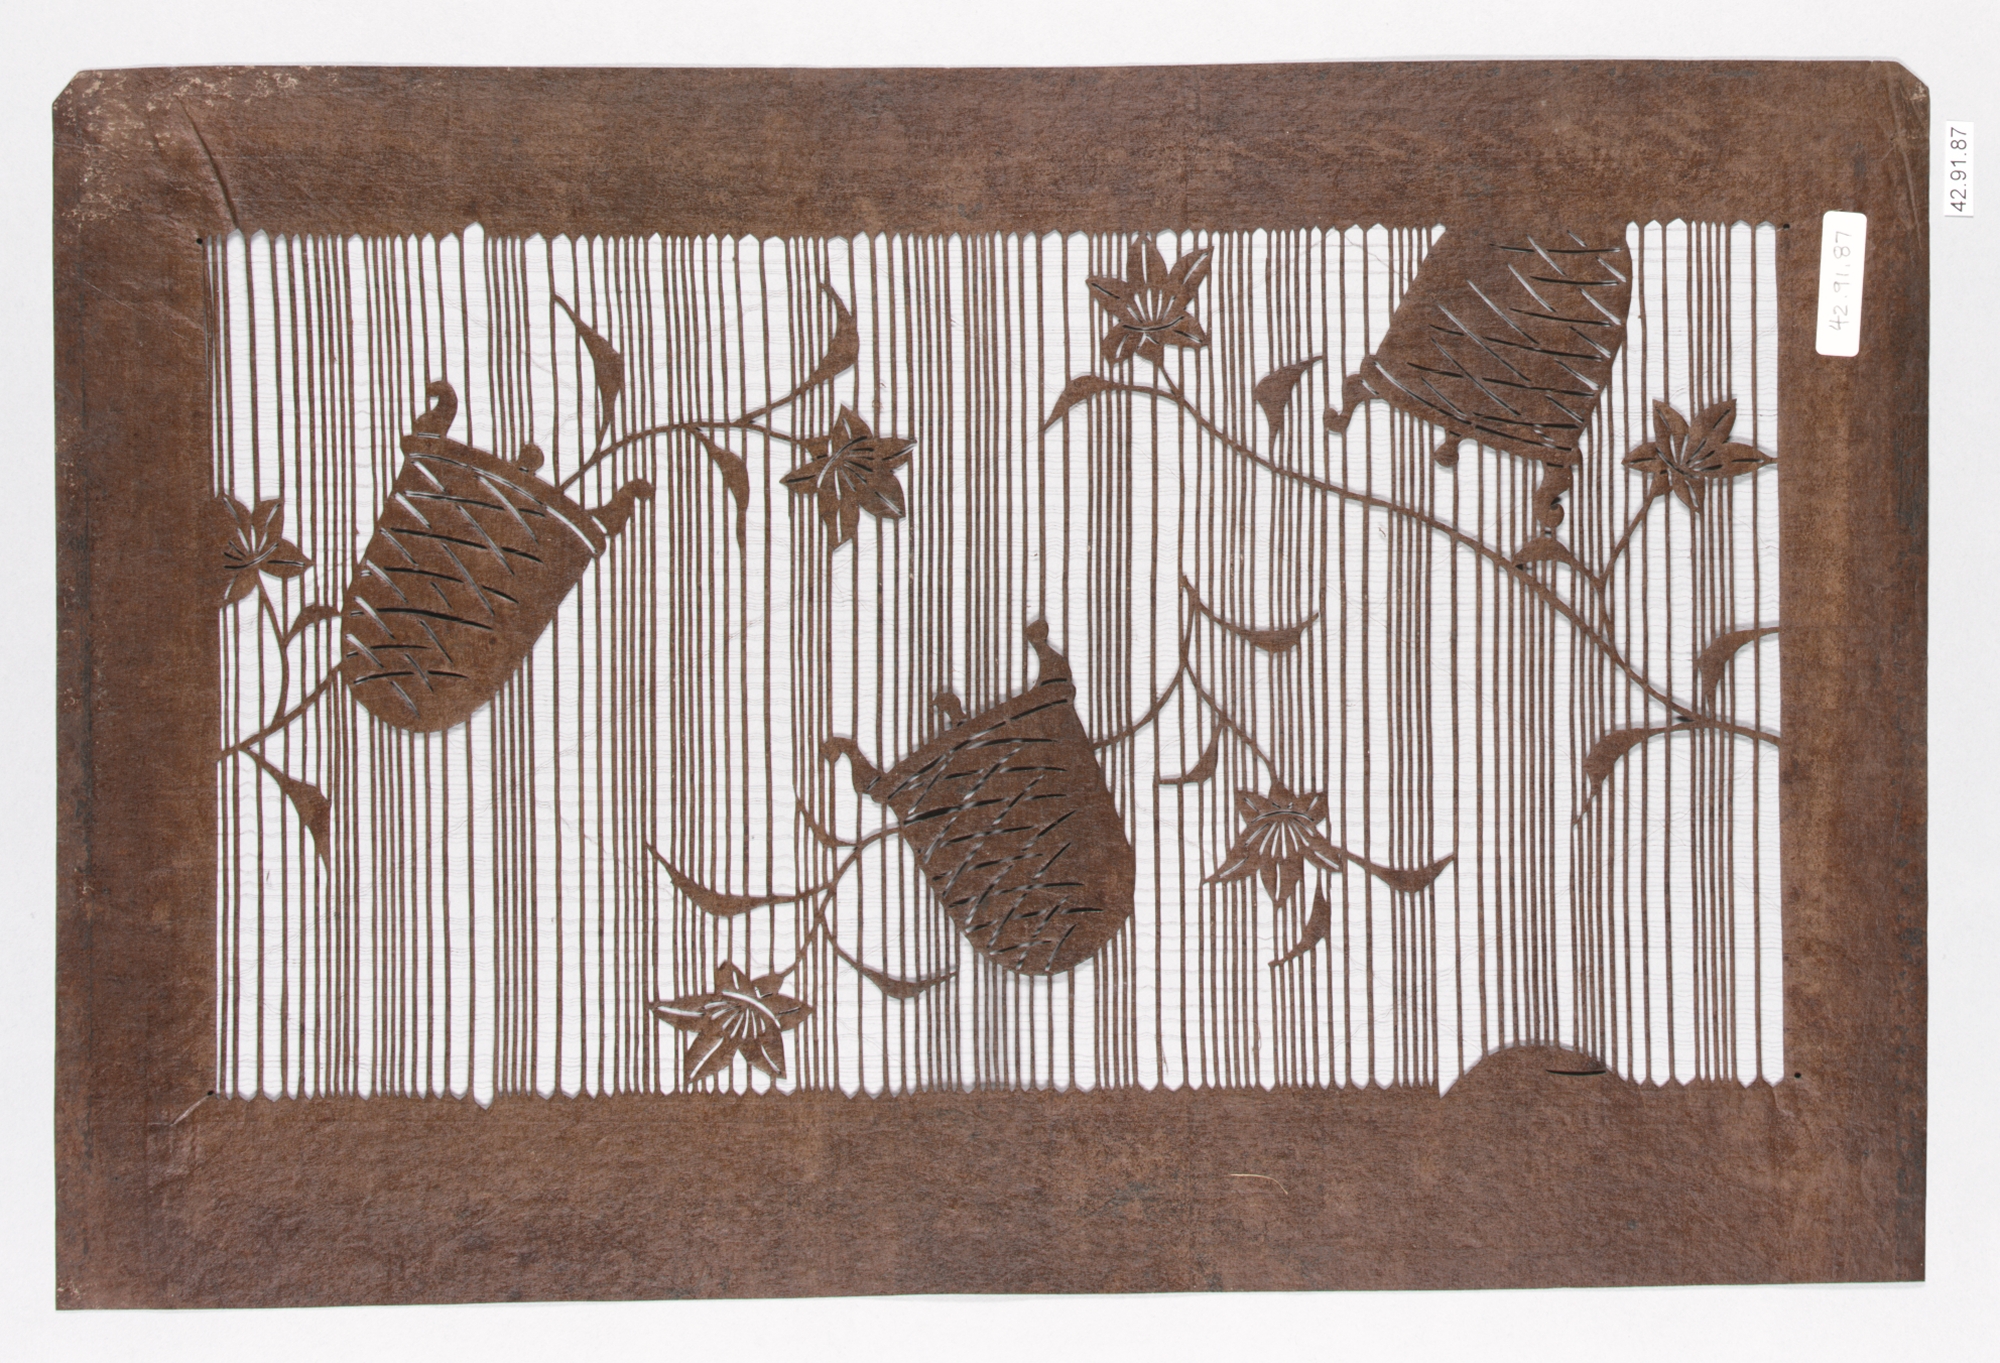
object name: stencil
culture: japanese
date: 1801-1900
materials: paper, silk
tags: flowers